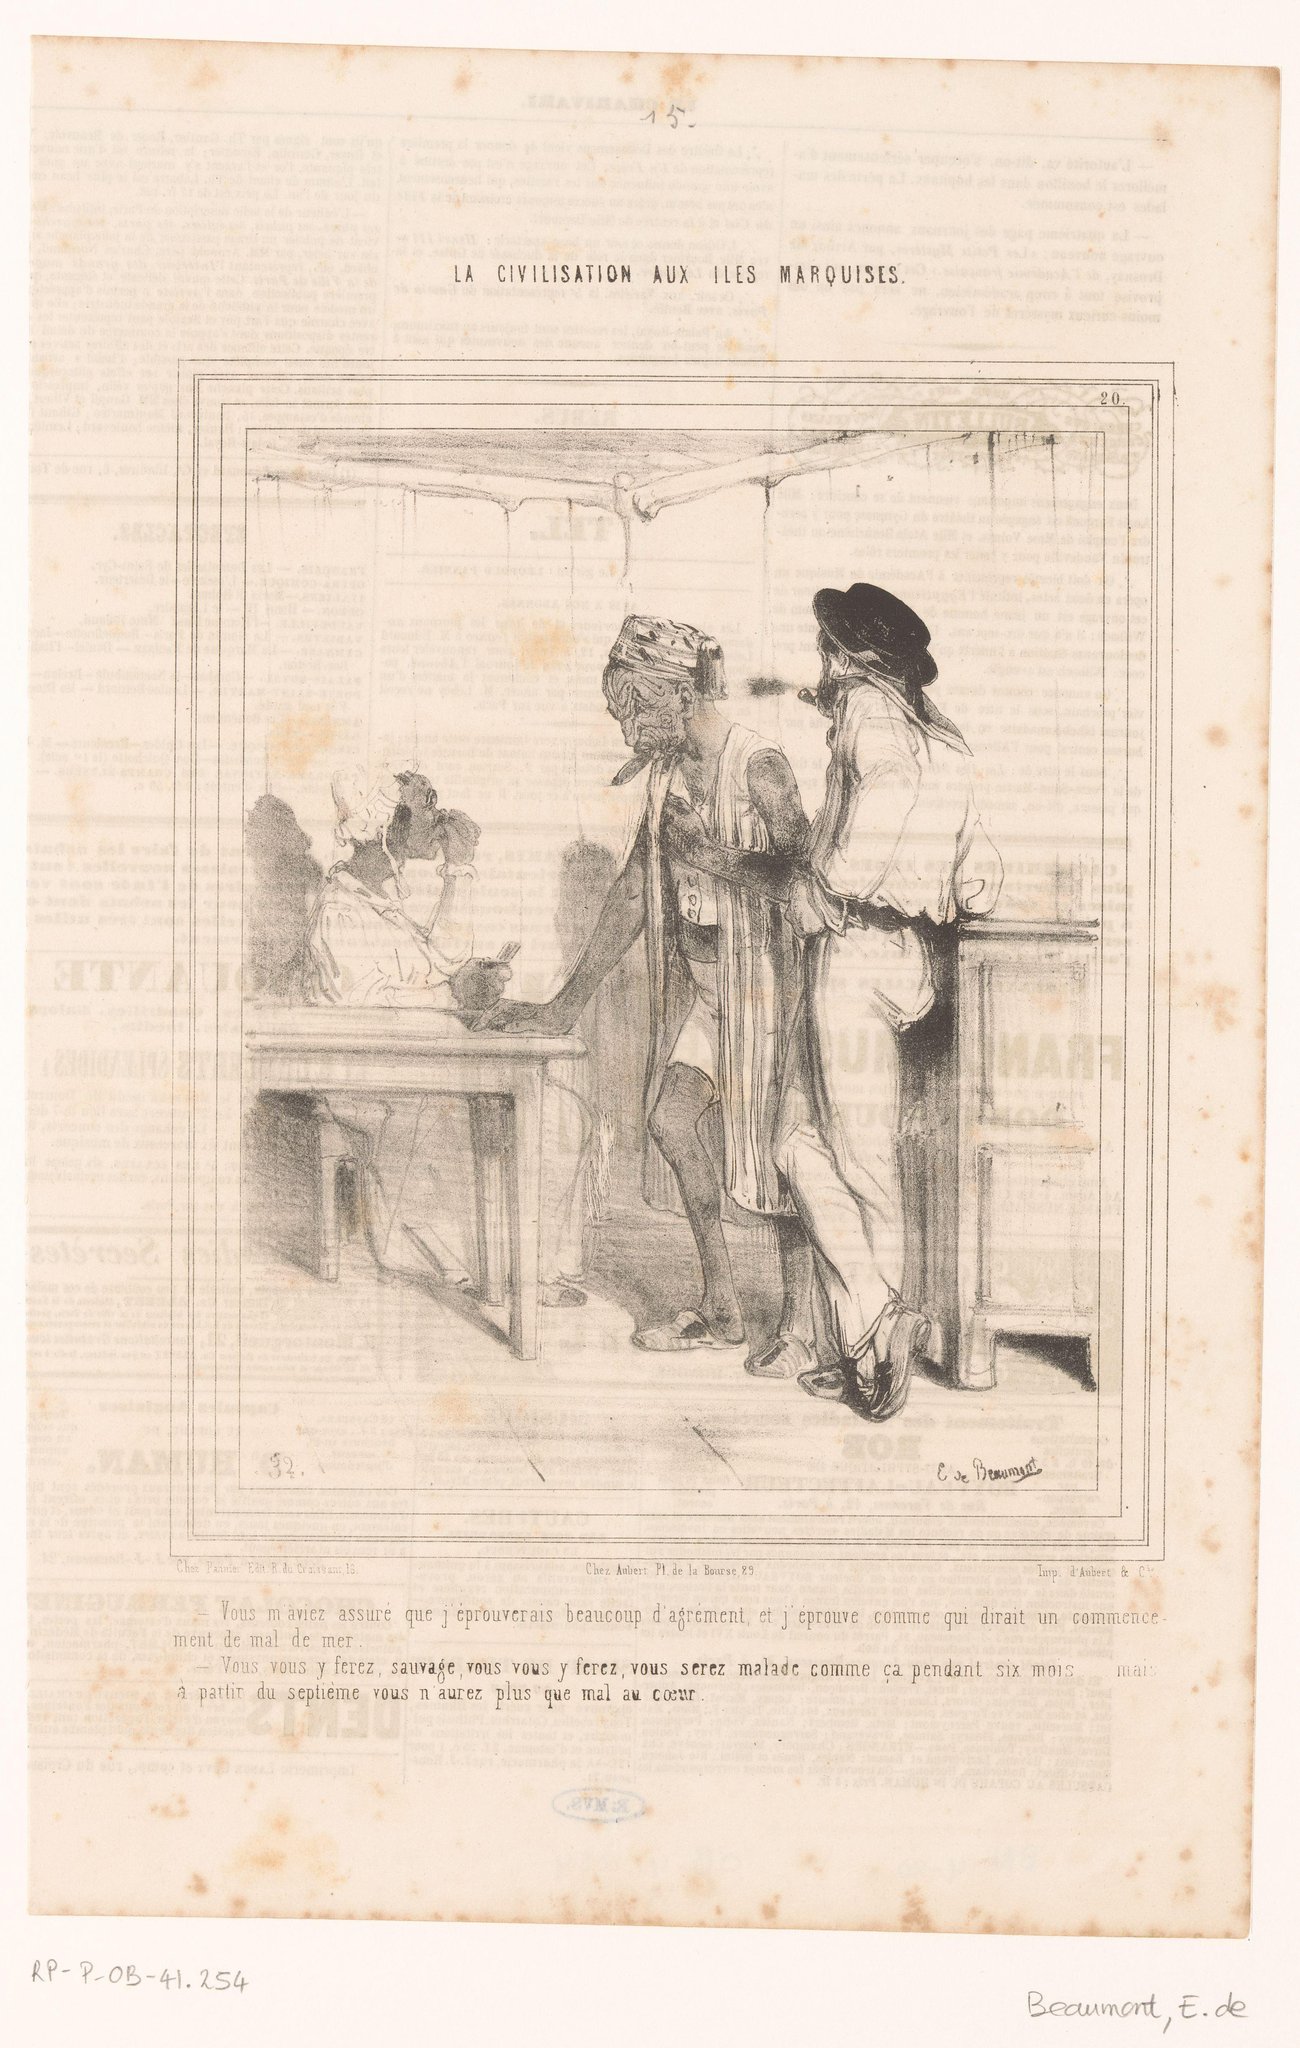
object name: cartoon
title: Vous m'aviez assuré (...)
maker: edouard de beaumont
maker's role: draughtsman, painter, print maker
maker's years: 1812-1888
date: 1843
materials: paper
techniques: letterpress printing, lithograph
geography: paris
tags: colonial system, sea-sickness, australian and oceanian races (+ caricatured), marquesas archipelago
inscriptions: collector's mark: Lugt 2228a, number: ‘15’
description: Een oorspronkelijke inwoner van de Markiezenarchipel voelt zich zeeziek aan boord van een schip. De Franse matroos verzekert hem dat hij na zes maanden misselijkheid alleen nog maar hartzeer zal ervaren.